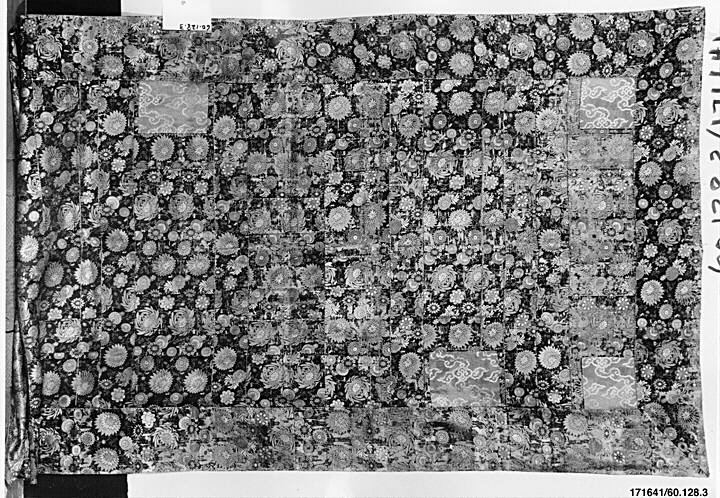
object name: robe, priest's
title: Priest's Robe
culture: japanese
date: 1701-1800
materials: metal thread, silk